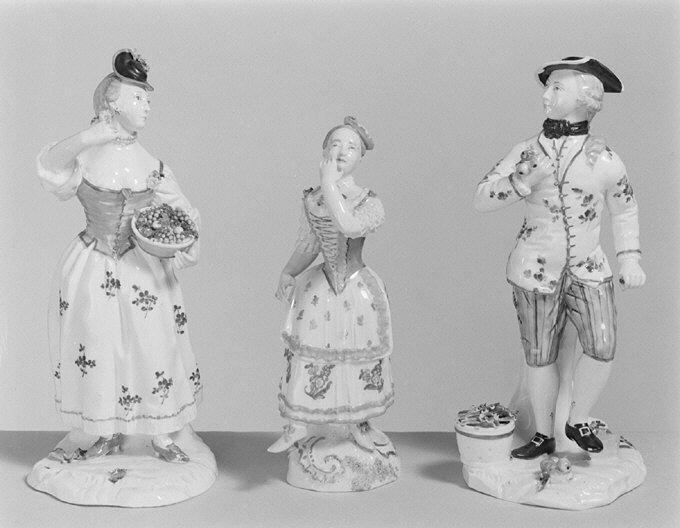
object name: figure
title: Dancing girl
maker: ansbach pottery and porcelain manufactory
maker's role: manufactory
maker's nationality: german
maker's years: 1758-1860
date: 1760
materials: hard paste porcelain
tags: girls,dancing